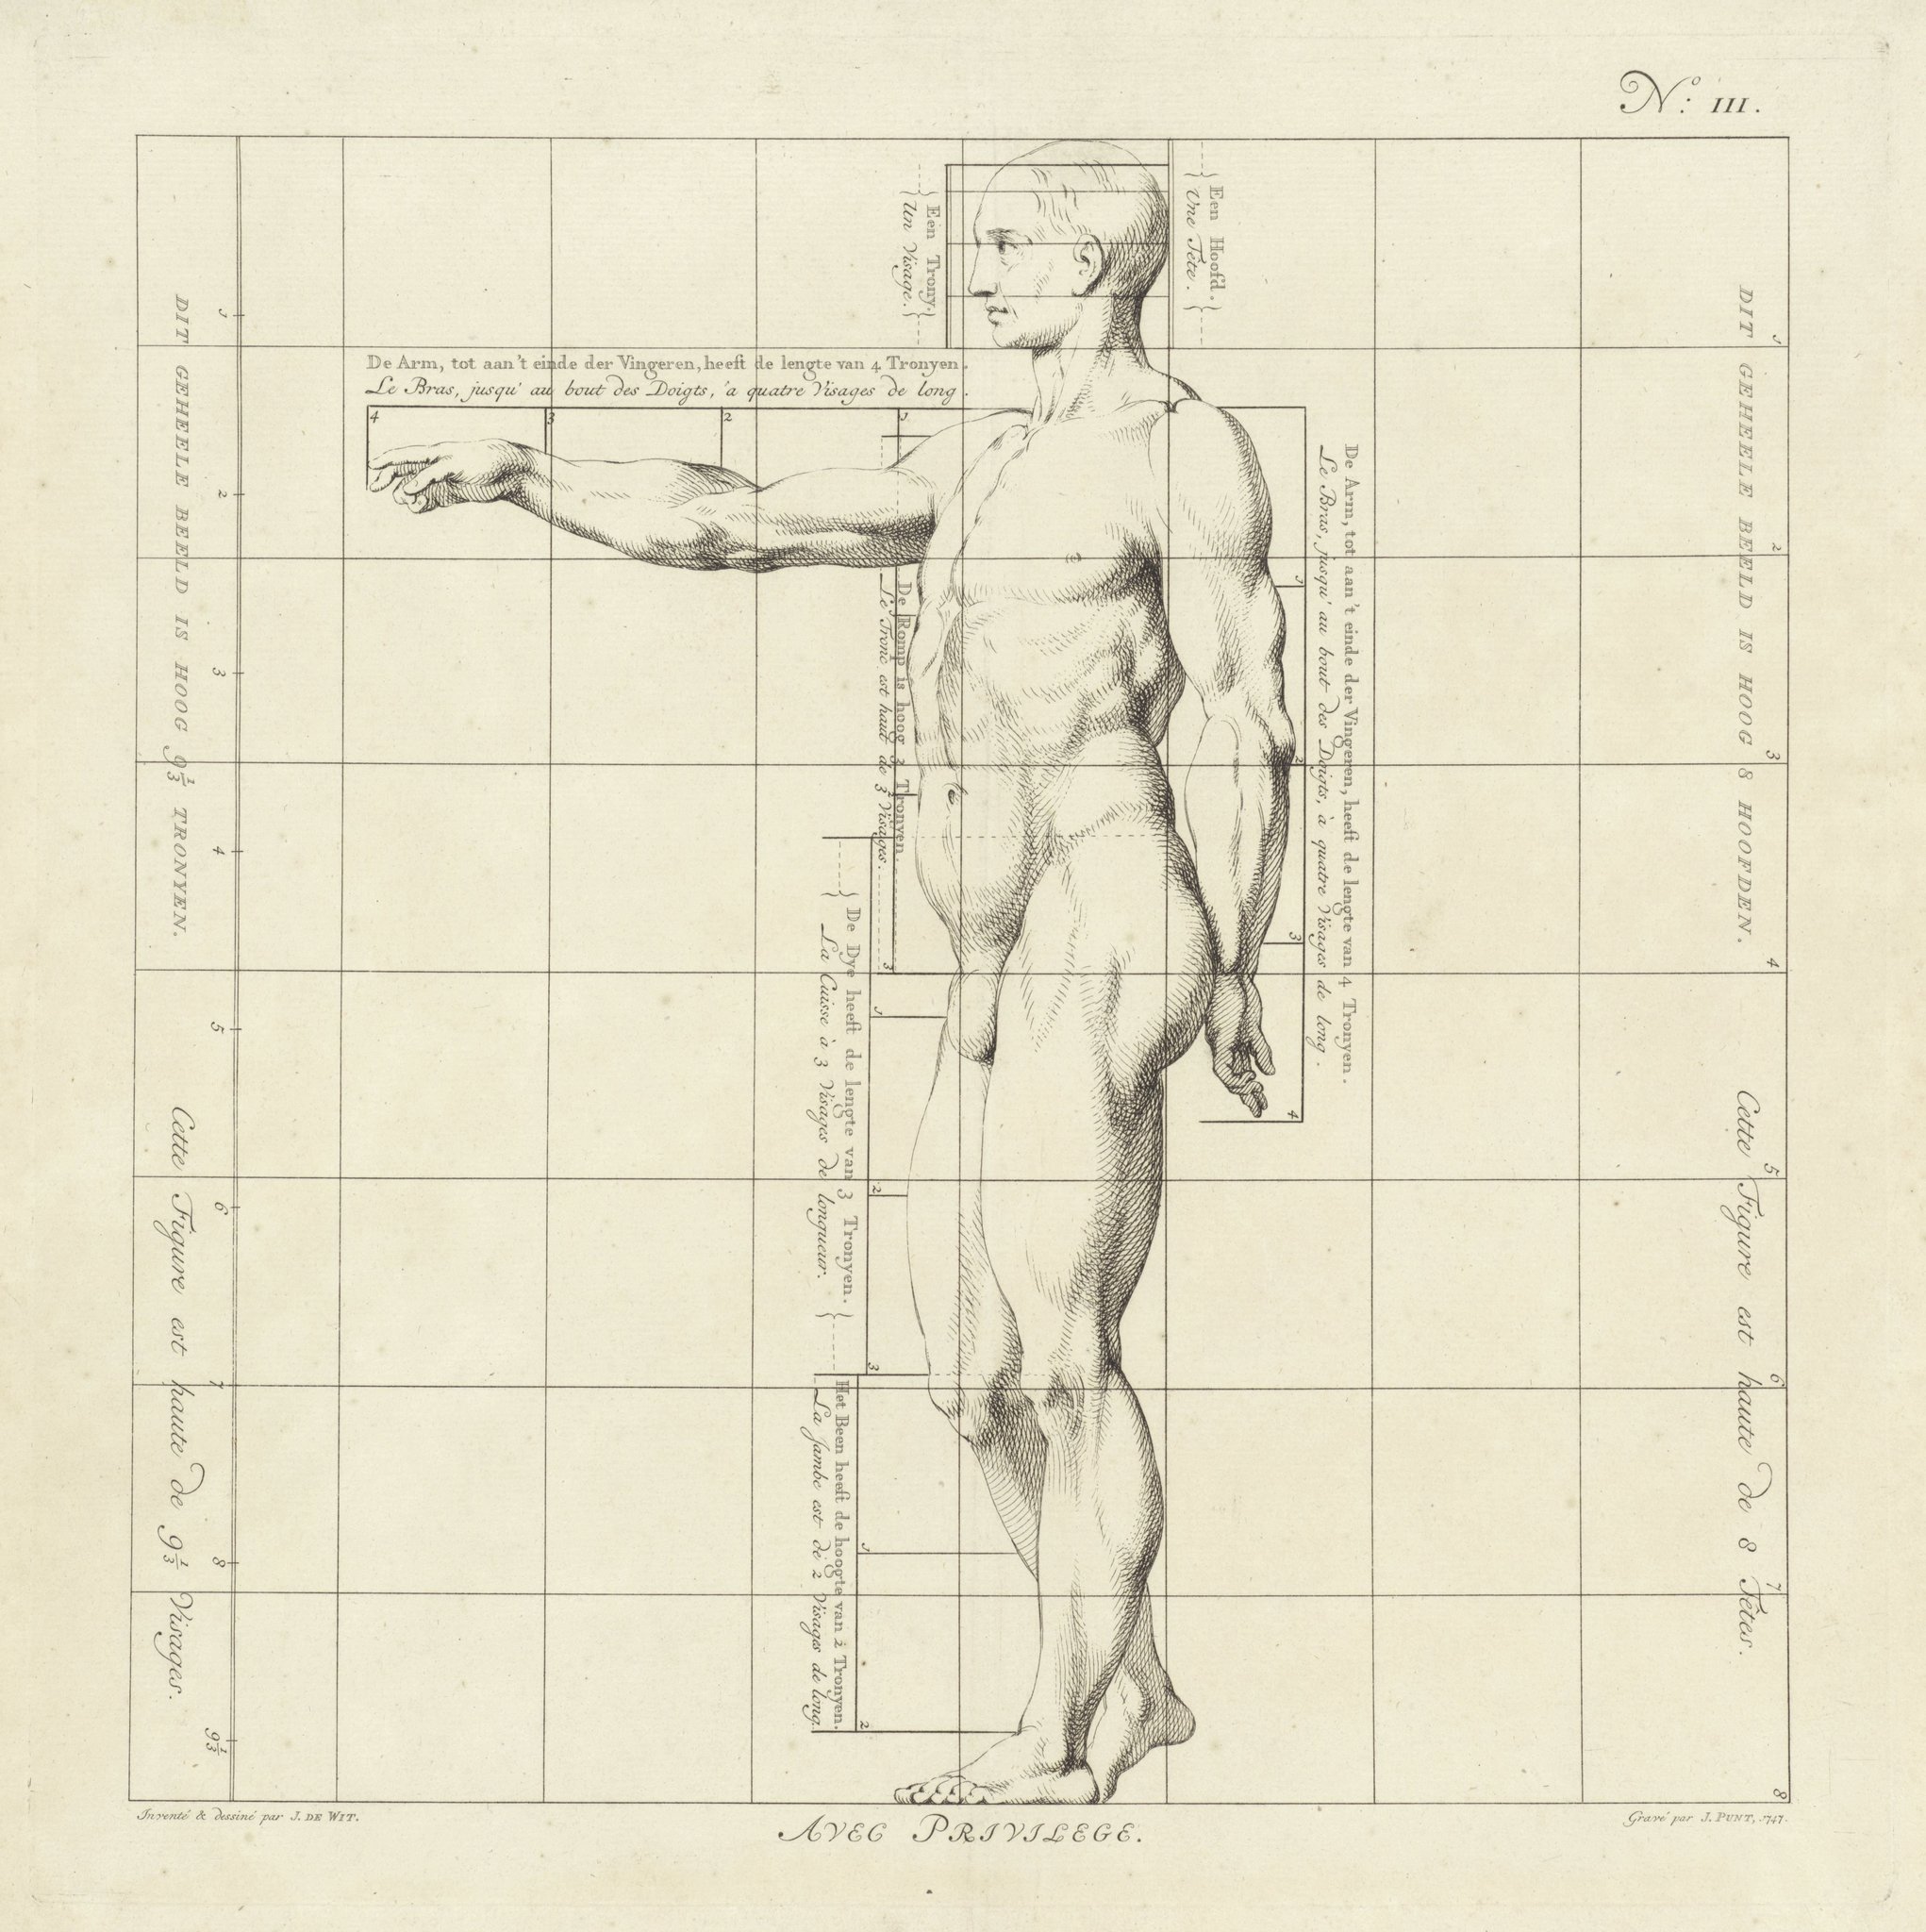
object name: print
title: Proportiestudie van het lichaam van een man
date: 1747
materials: paper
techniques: engraving, etching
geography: amsterdam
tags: standing figure (canon, proportions) (+ three-quarter view)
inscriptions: collector's mark: Lugt 2228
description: Prent uit: Wit, Jacob de. Teekenboek der proportien van 't menschelyke lighaam. = Proportions du corps humain. Amsterdam: Isaak Tirion, 1747.